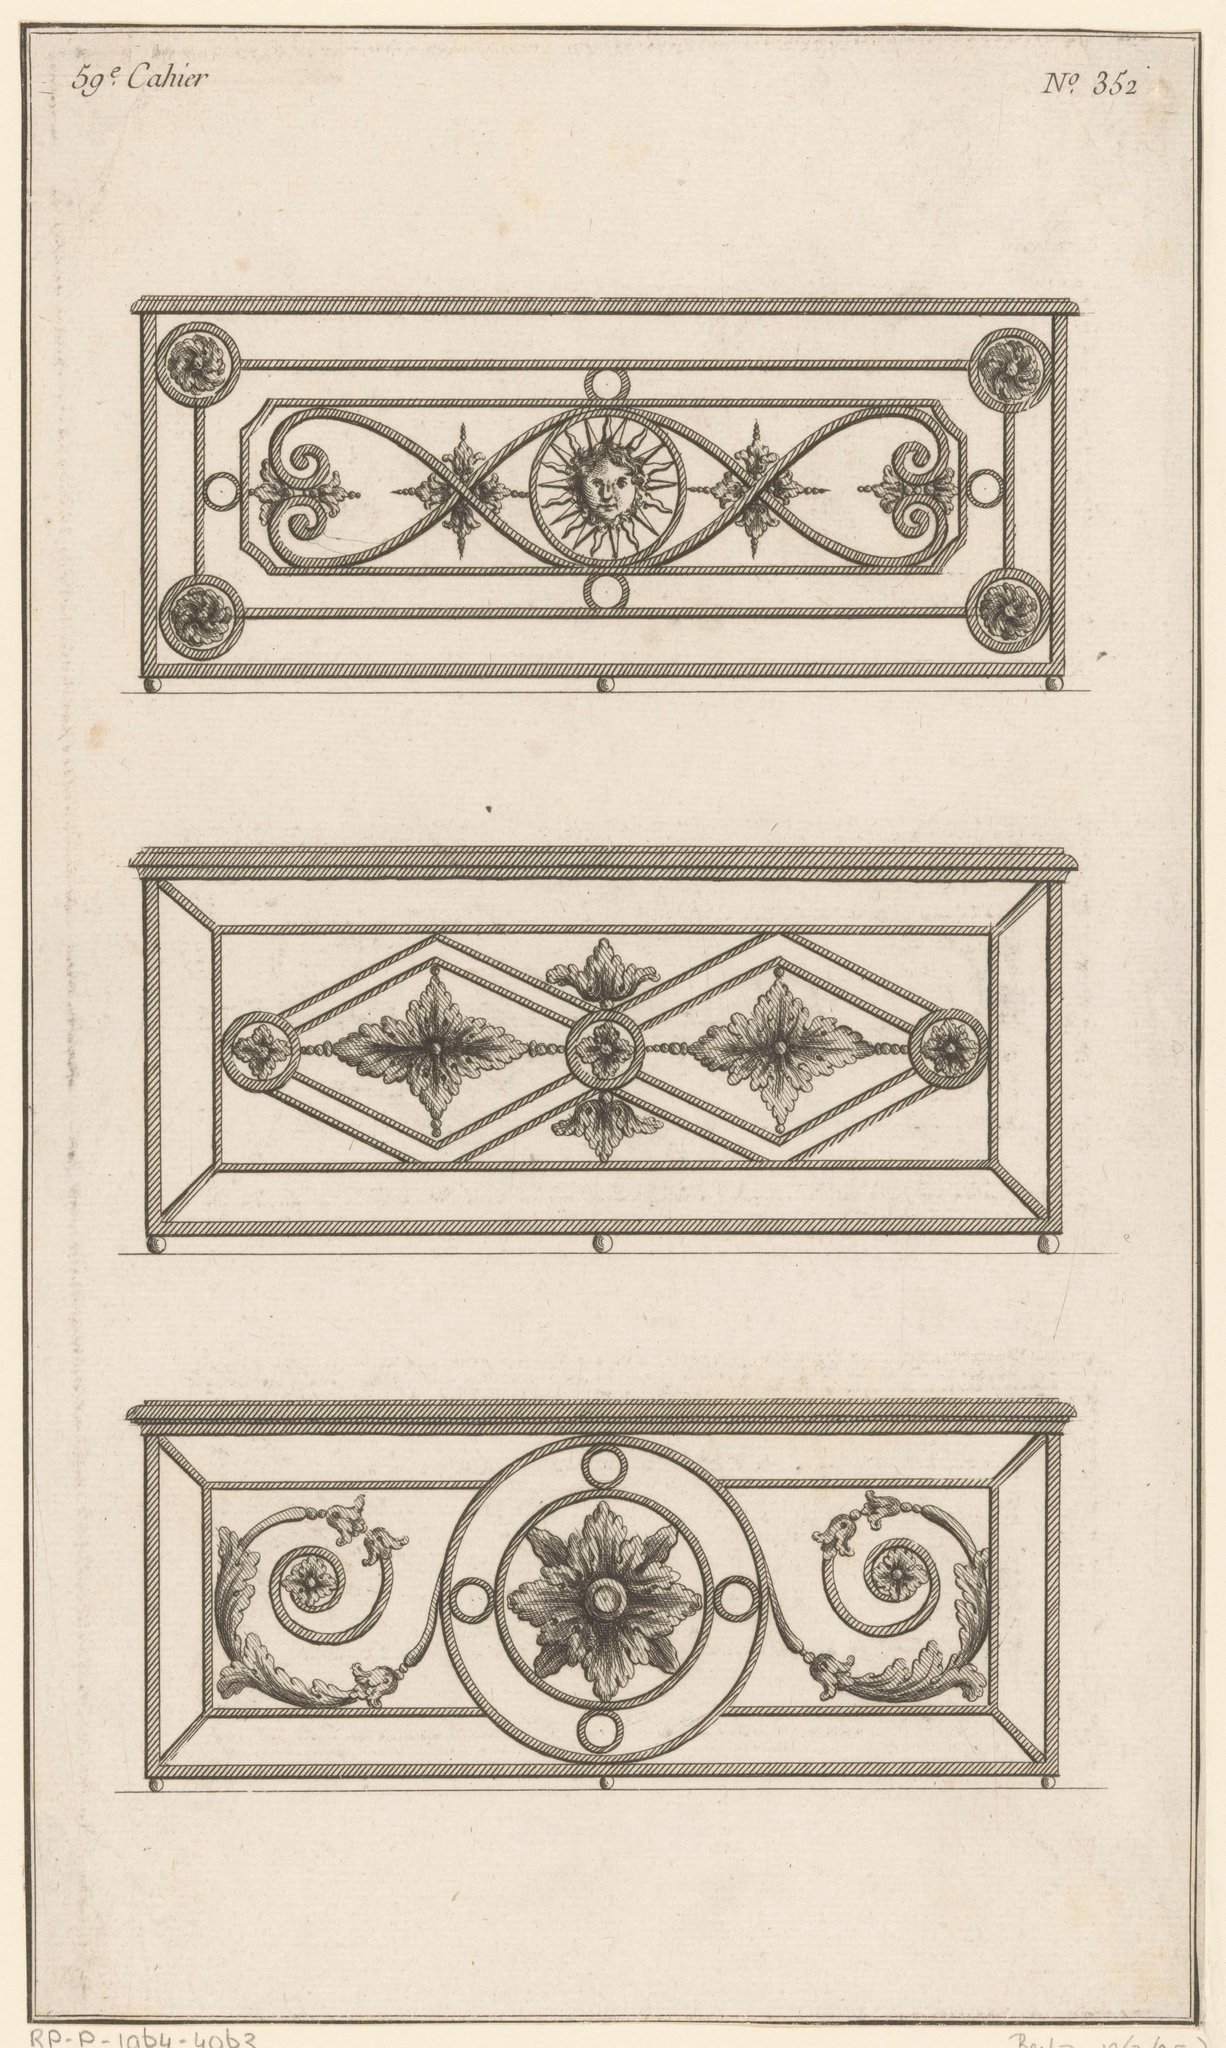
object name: print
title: Hekken met bloemmotieven en zon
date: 1772-1779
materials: paper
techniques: engraving, etching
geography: paris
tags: fence, wall, paling, sun represented as face, wheel, etc., flowers ~ ornament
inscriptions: collector's mark: Lugt 2760, collector's mark: Lugt 2228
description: Drie smeedijzeren hekken met bloemmotieven en de zon als een gezicht. Prentnummer 352.